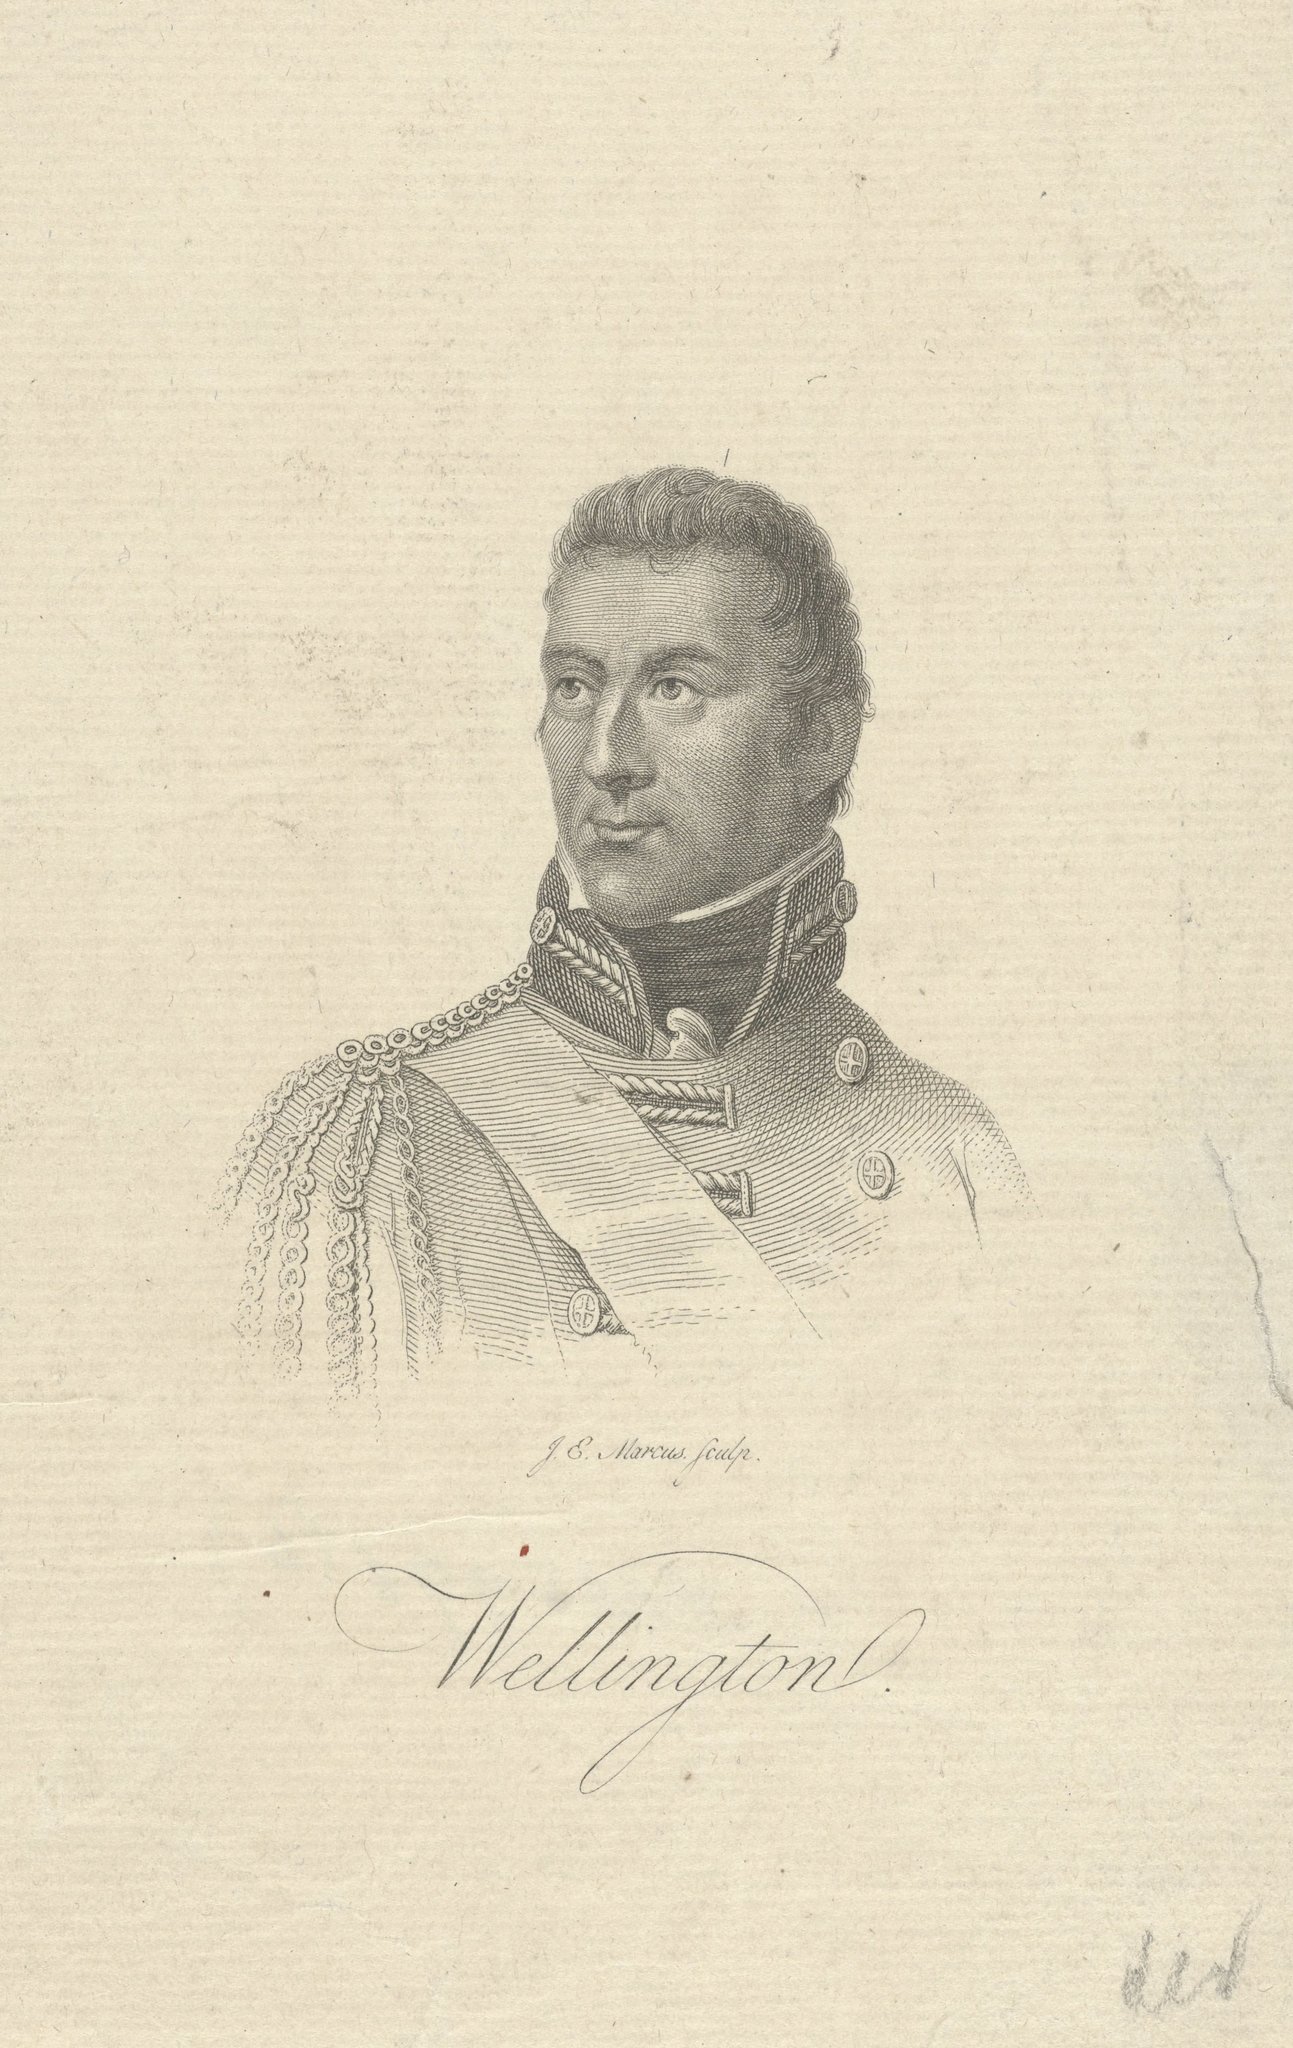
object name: print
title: Portret van Arthur Wellesley, hertog van Wellington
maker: jacob ernst marcus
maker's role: draughtsman, print maker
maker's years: 1774-1826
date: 1814-1826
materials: paper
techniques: engraving, etching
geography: amsterdam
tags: walmer castle, arthur wellesley of wellington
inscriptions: collector's mark: Lugt 2228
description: Buste van de veldmaarschalk van het Engelse leger, Arthur Wellesley hertog van Wellington. Met dit Engelse leger en het Pruisische leger won koning Willem II in 1815 de Slag bij Waterloo.